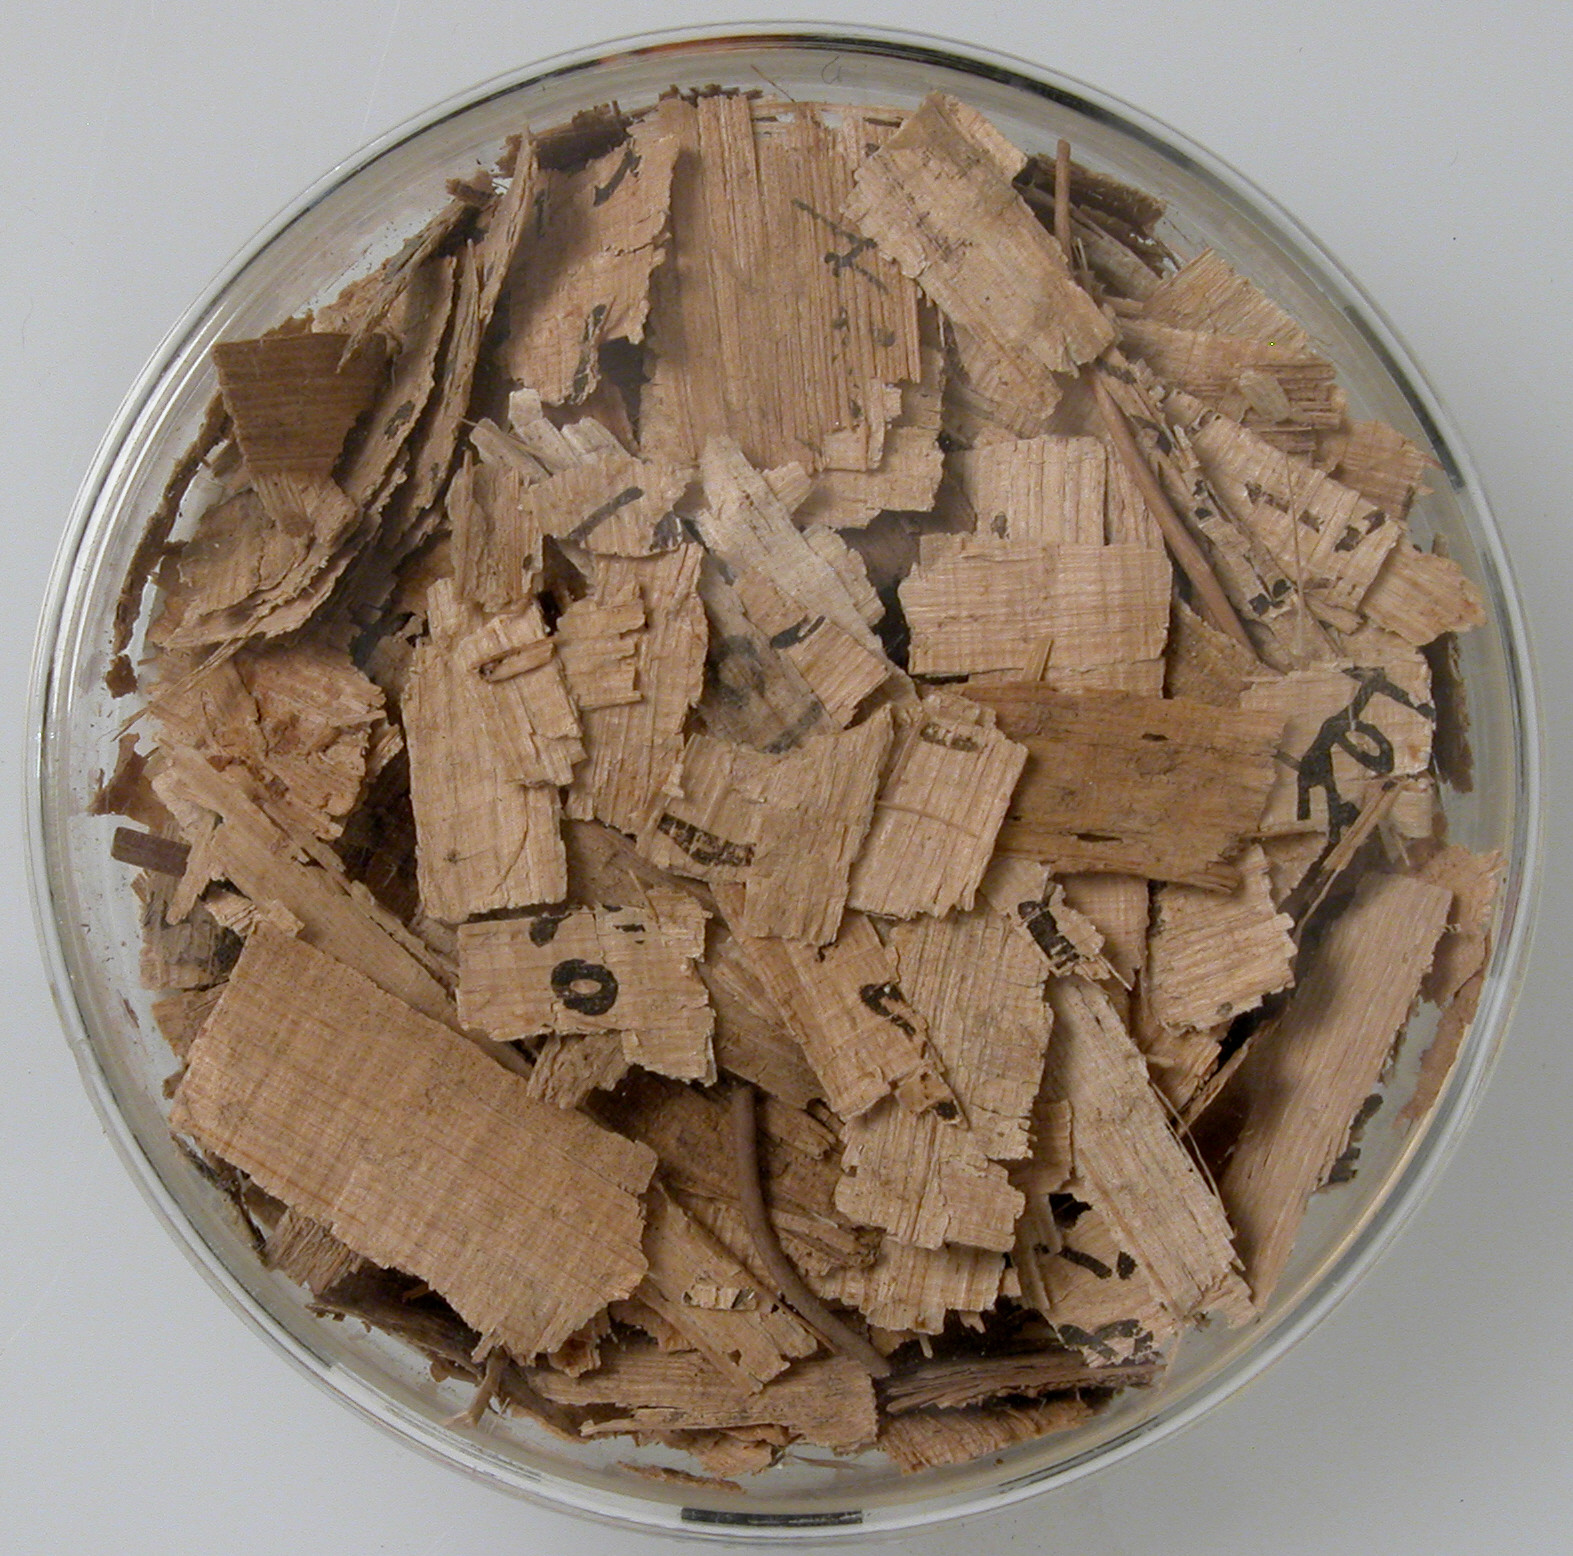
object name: fragment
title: Papyri Fragments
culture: coptic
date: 601-700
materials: ink, papyrus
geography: egypt